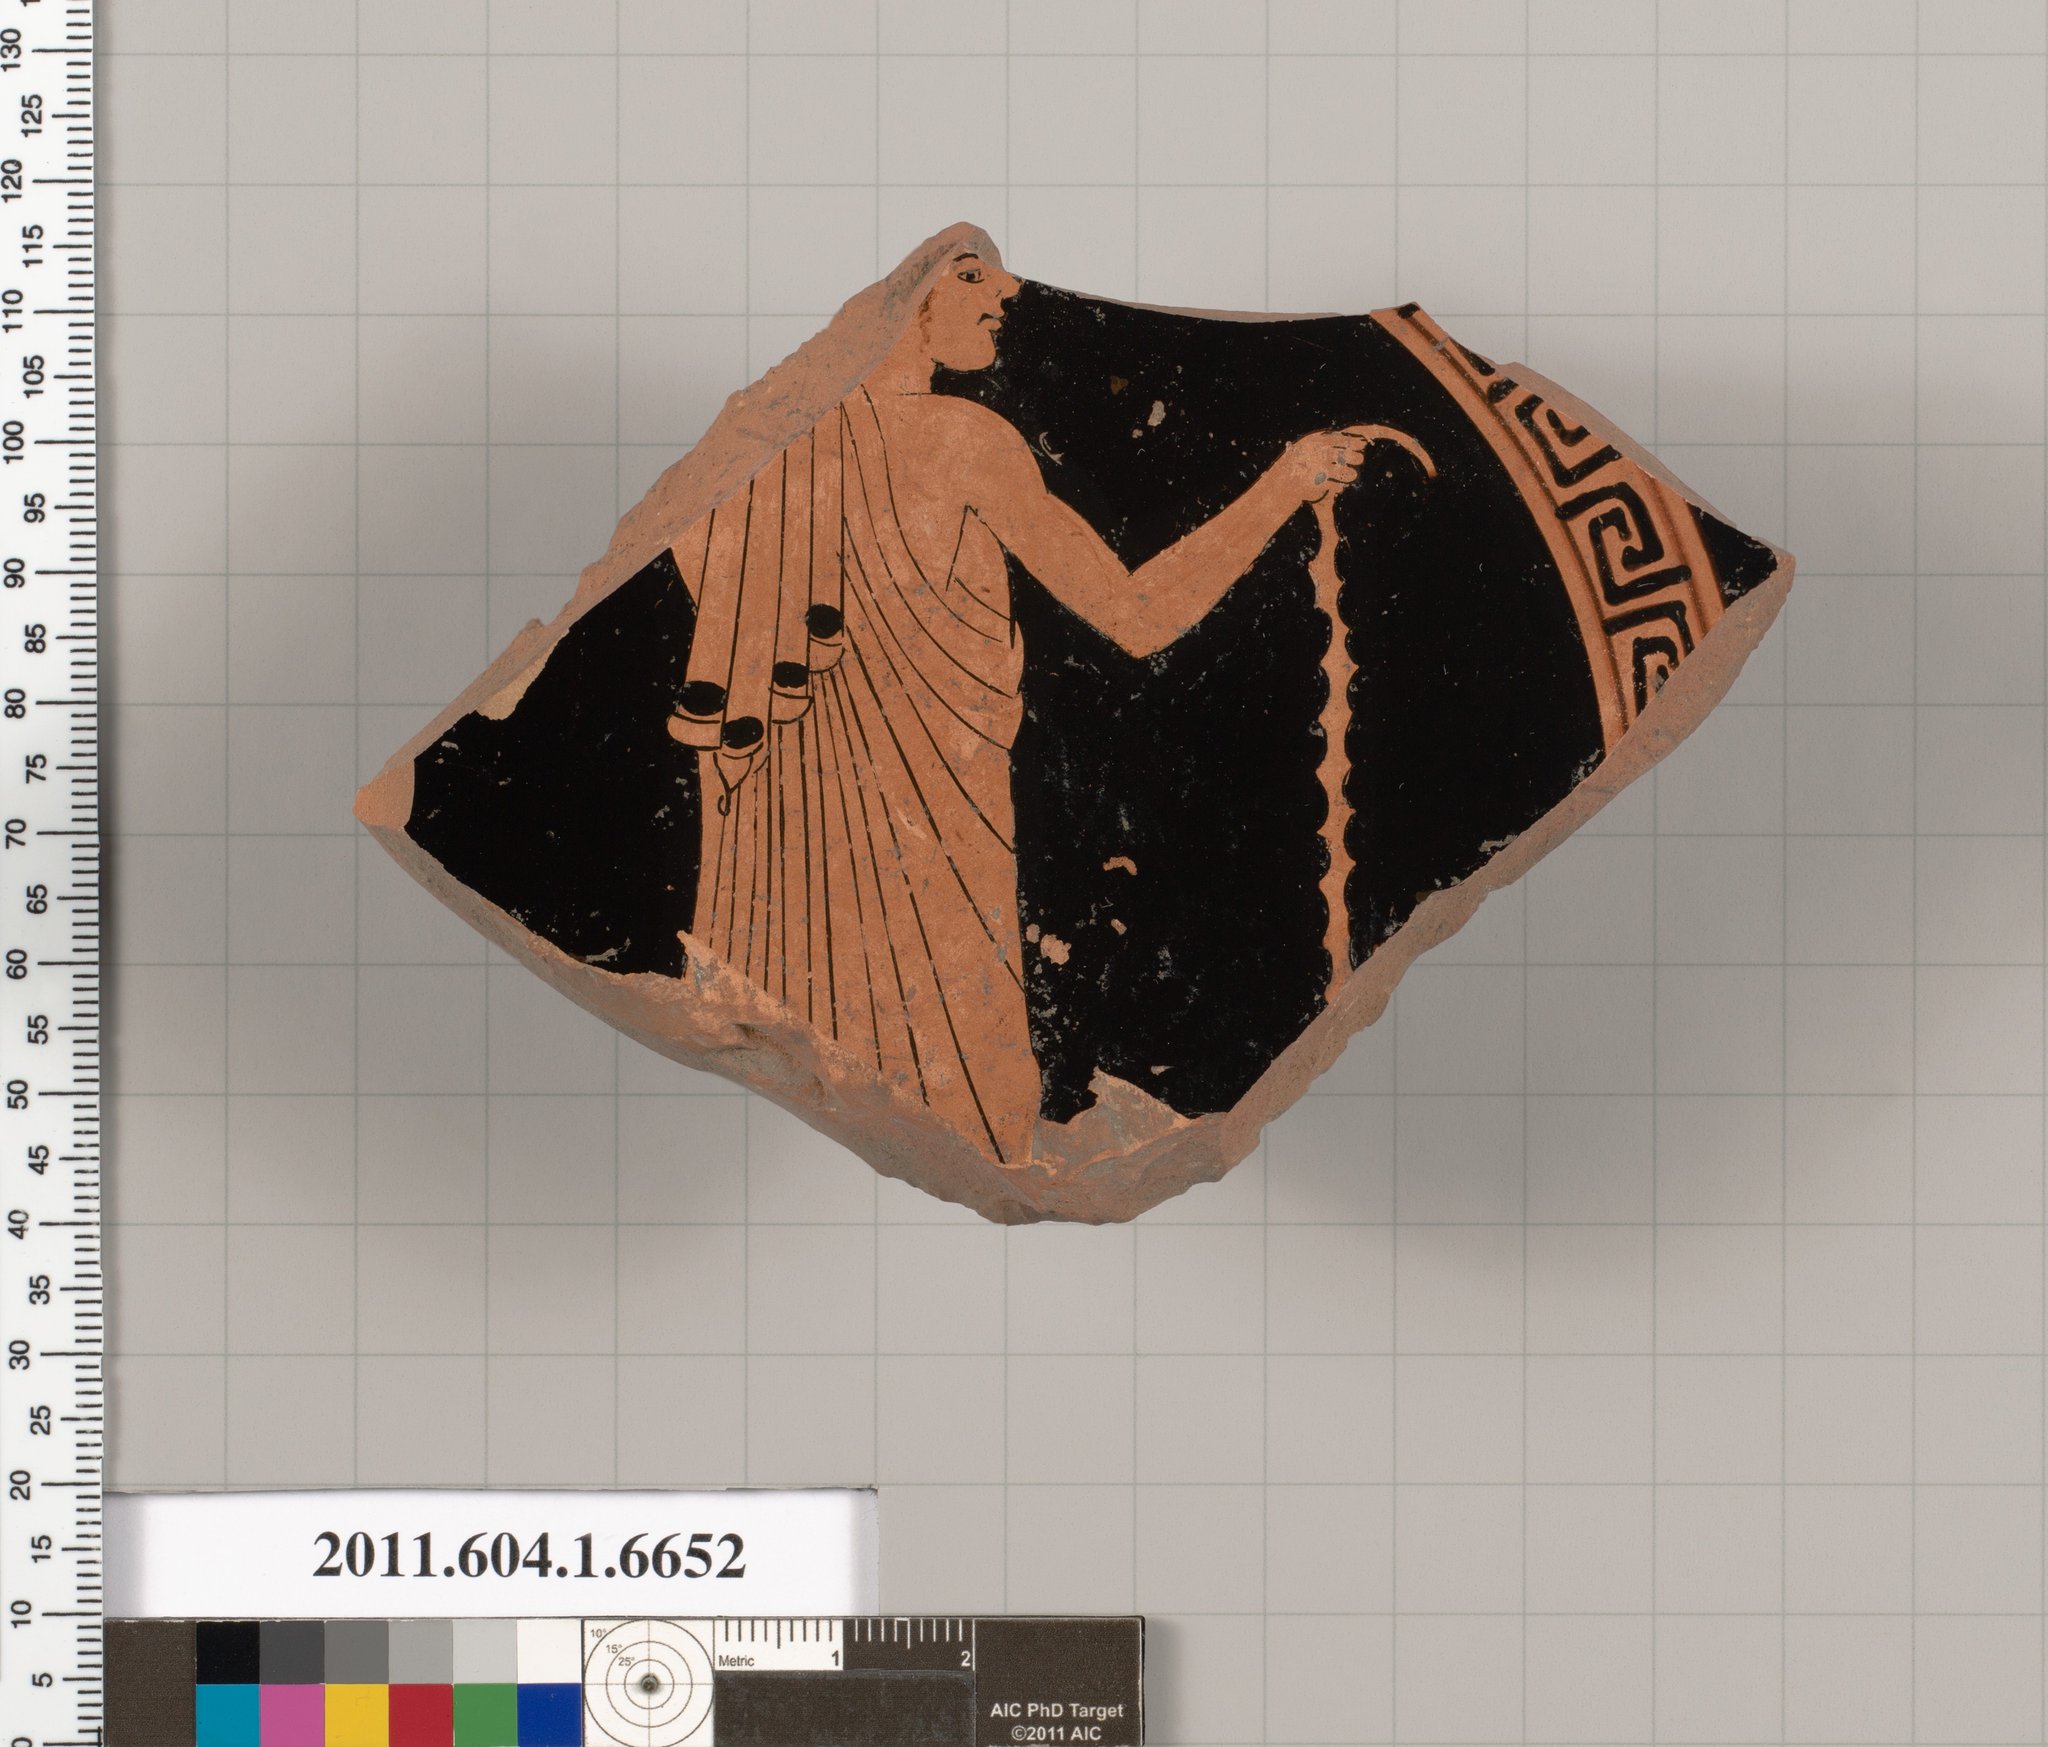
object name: kylix fragment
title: Terracotta fragment of a kylix (drinking cup)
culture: greek, attic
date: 490-470 BCE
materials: terracotta